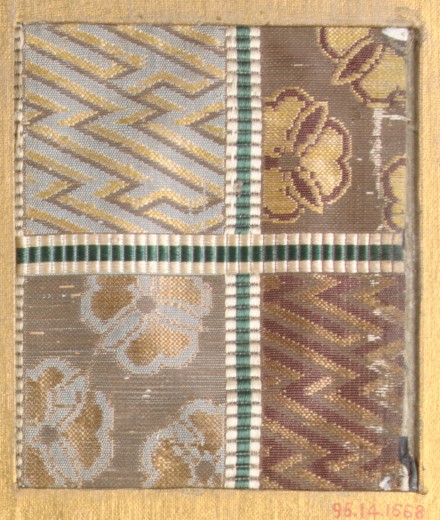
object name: piece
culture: japanese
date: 1701-1900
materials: silk